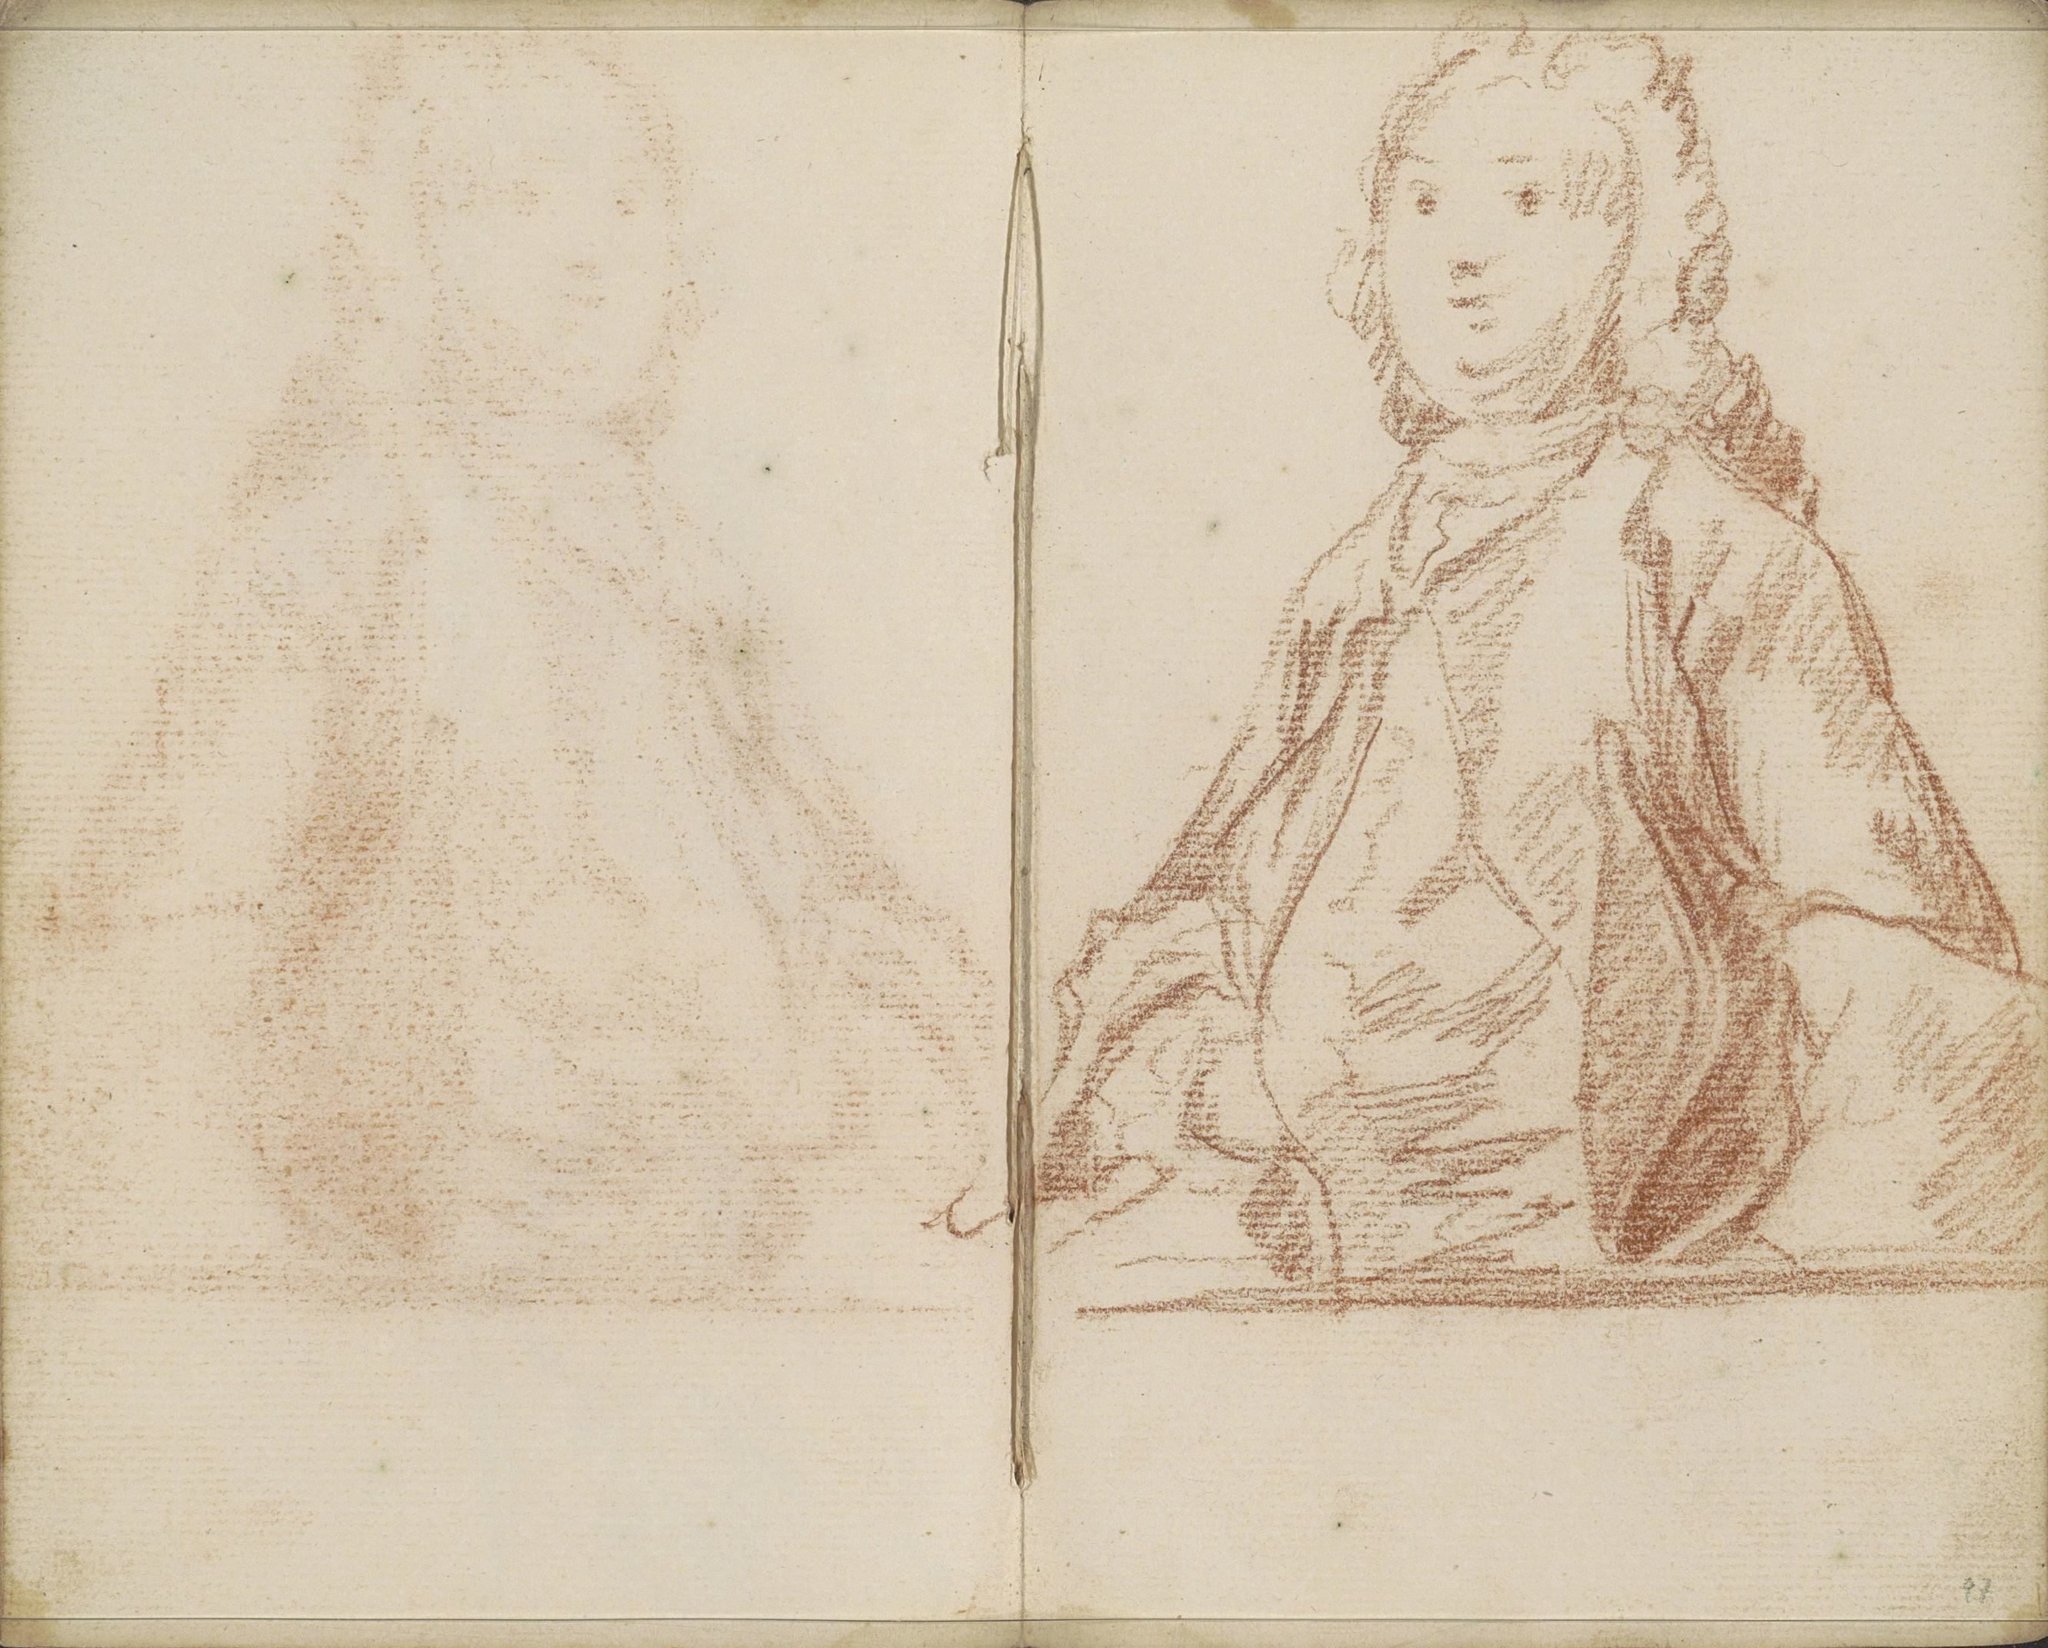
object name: sketchbook leaf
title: Man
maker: petrus johannes van reysschoot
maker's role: draughtsman, print maker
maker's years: 1702-1772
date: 1710-1772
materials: chalk, paper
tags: adult man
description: Blad 96 verso en 97 recto uit een schetsboek met 105 bladen.